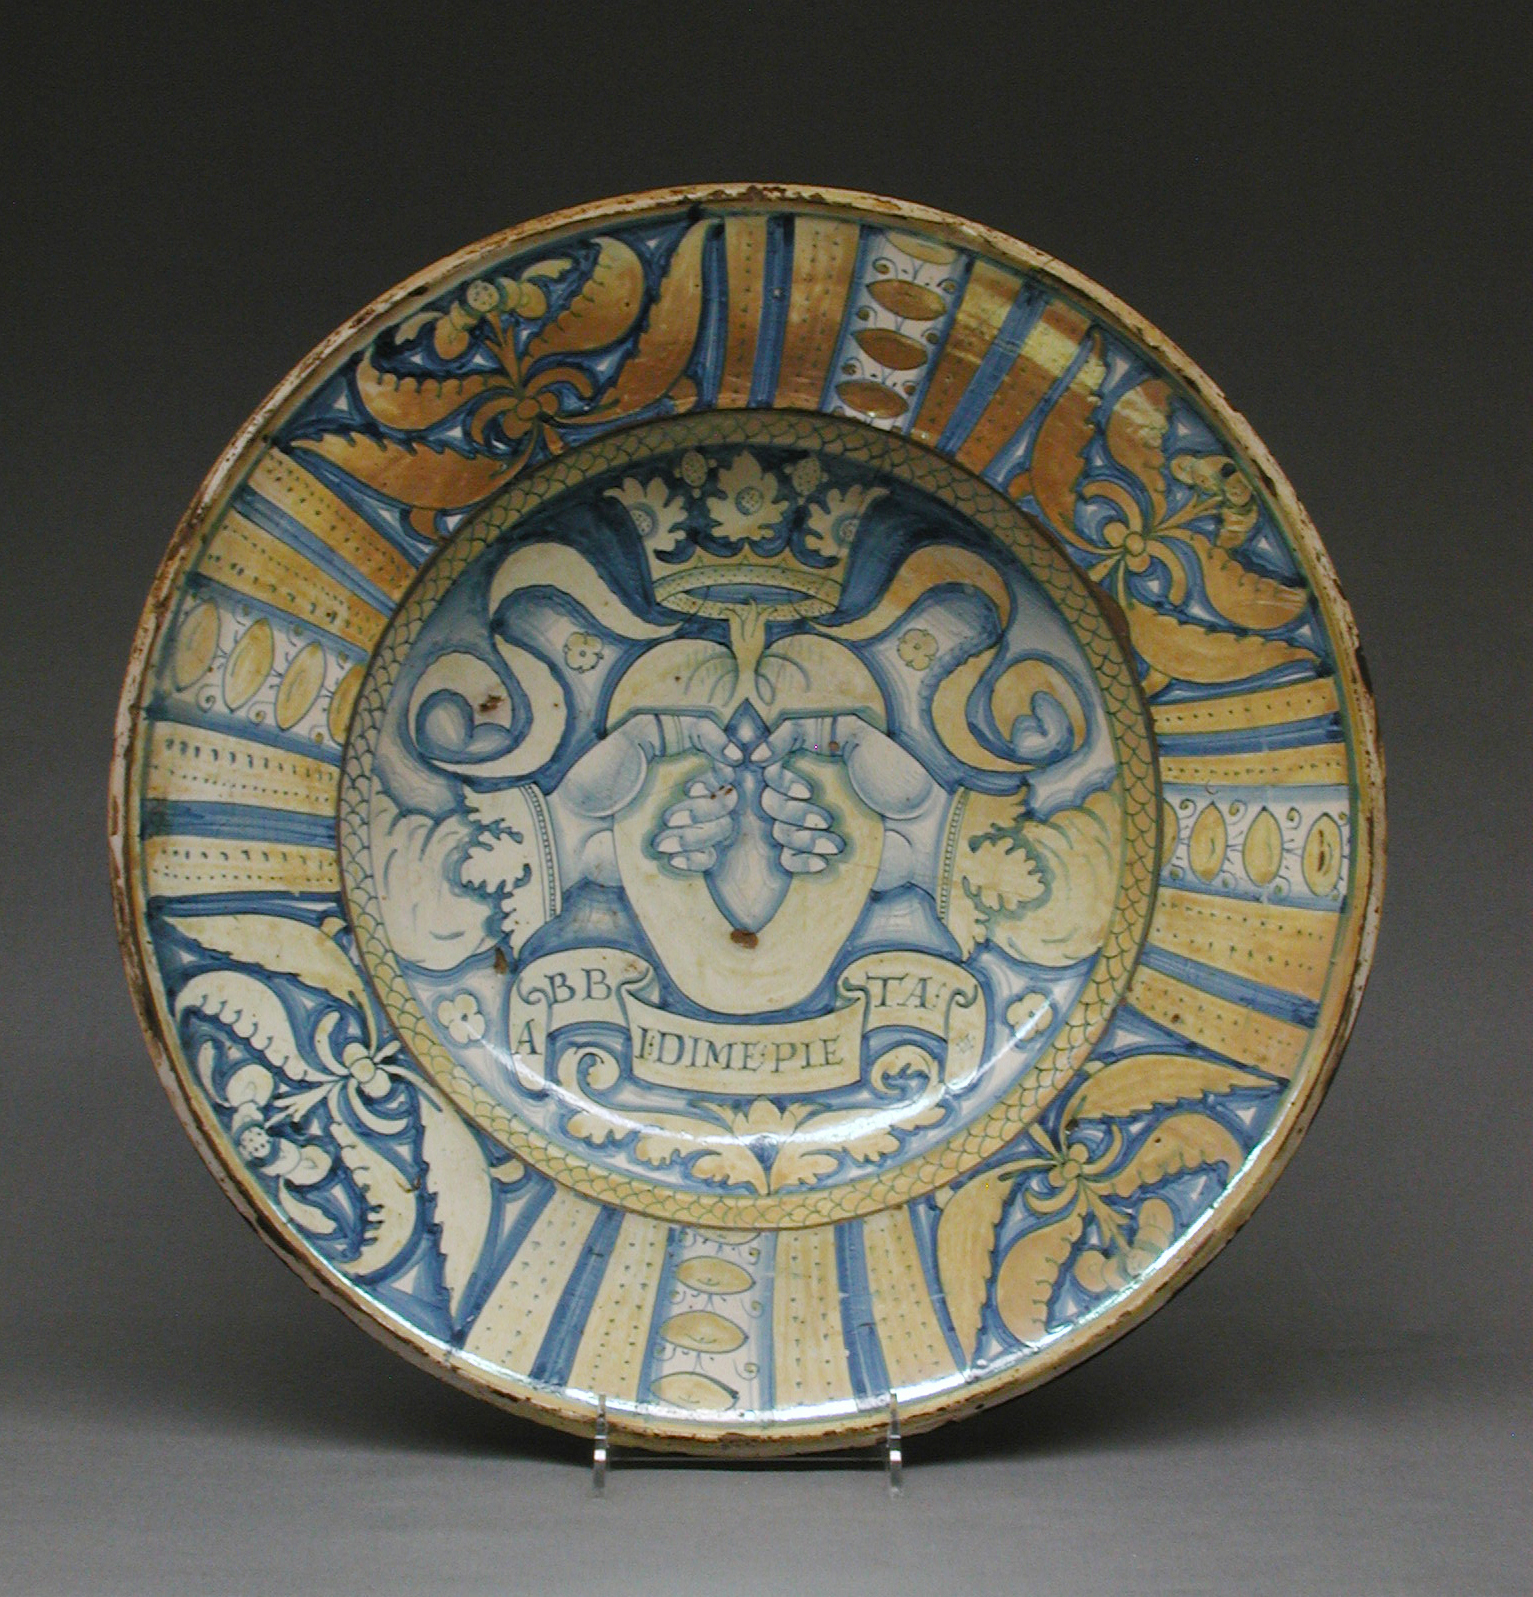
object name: dish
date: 1500-1510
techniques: maiolica, glazing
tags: coat of arms